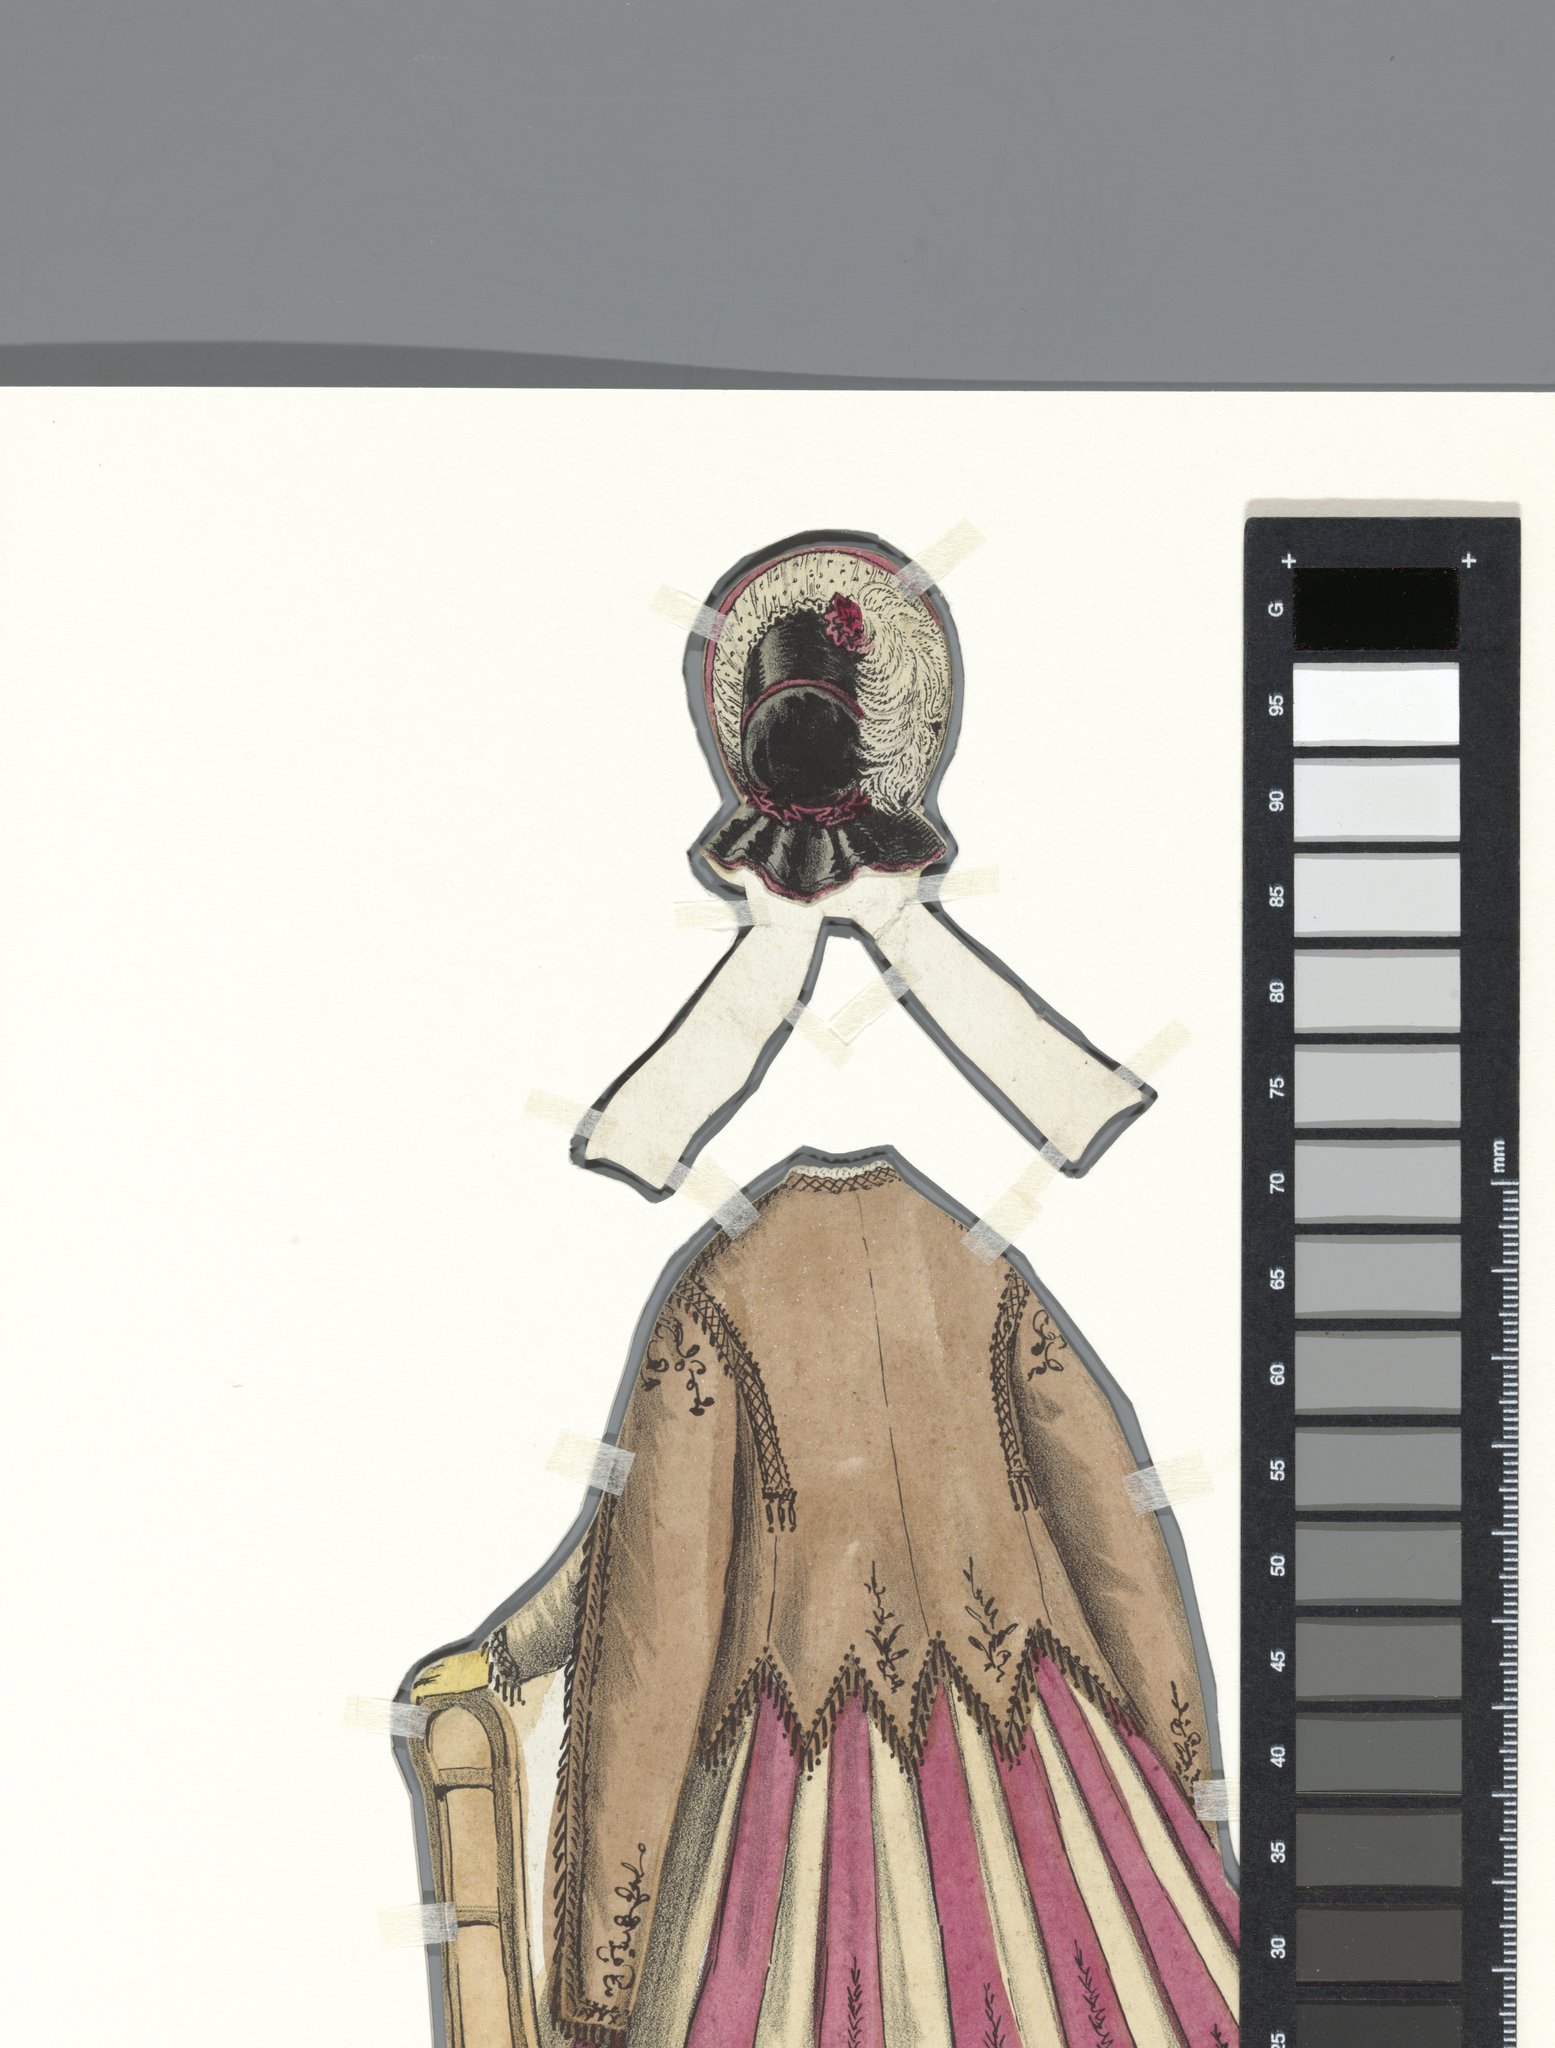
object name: fashion print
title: Achterzijde van een kapsel met muts voor een uitknippop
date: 1825-1875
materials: paper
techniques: engraving, hand coloring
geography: paris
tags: fashion plates